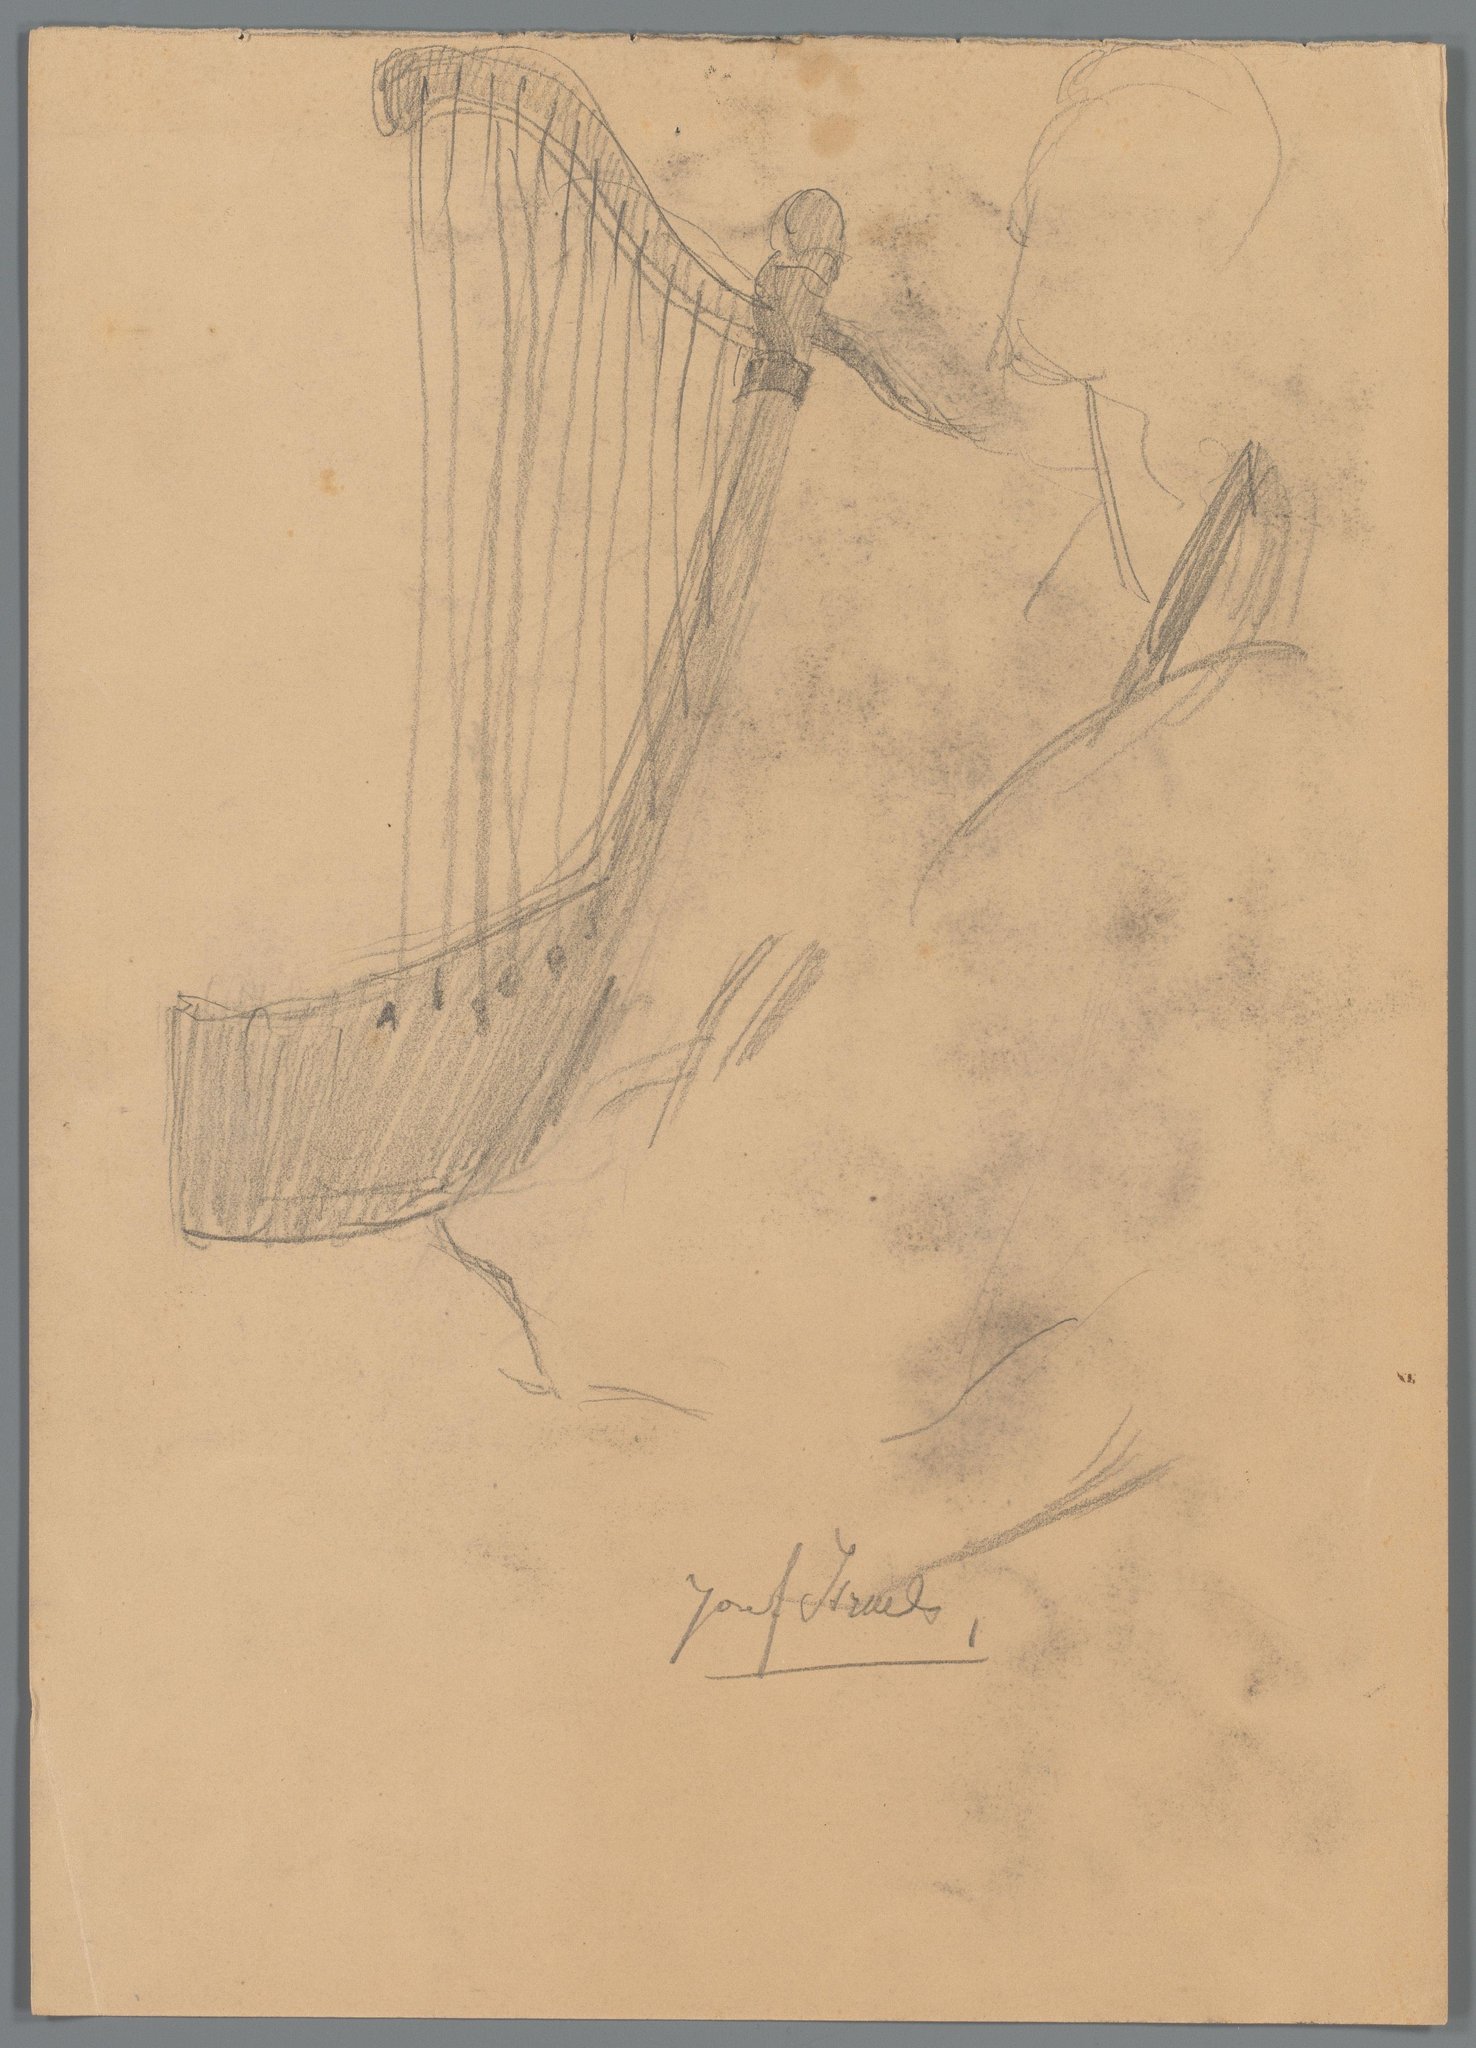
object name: drawing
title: Harp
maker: jozef israëls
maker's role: draughtsman, painter, print maker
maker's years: 1824-1911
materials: paper, pencil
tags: david as musician, usually playing the harp, harp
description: Voorstudie voor het schilderij 'David en Saul' dat zich in het Groninger Museum bevindt.